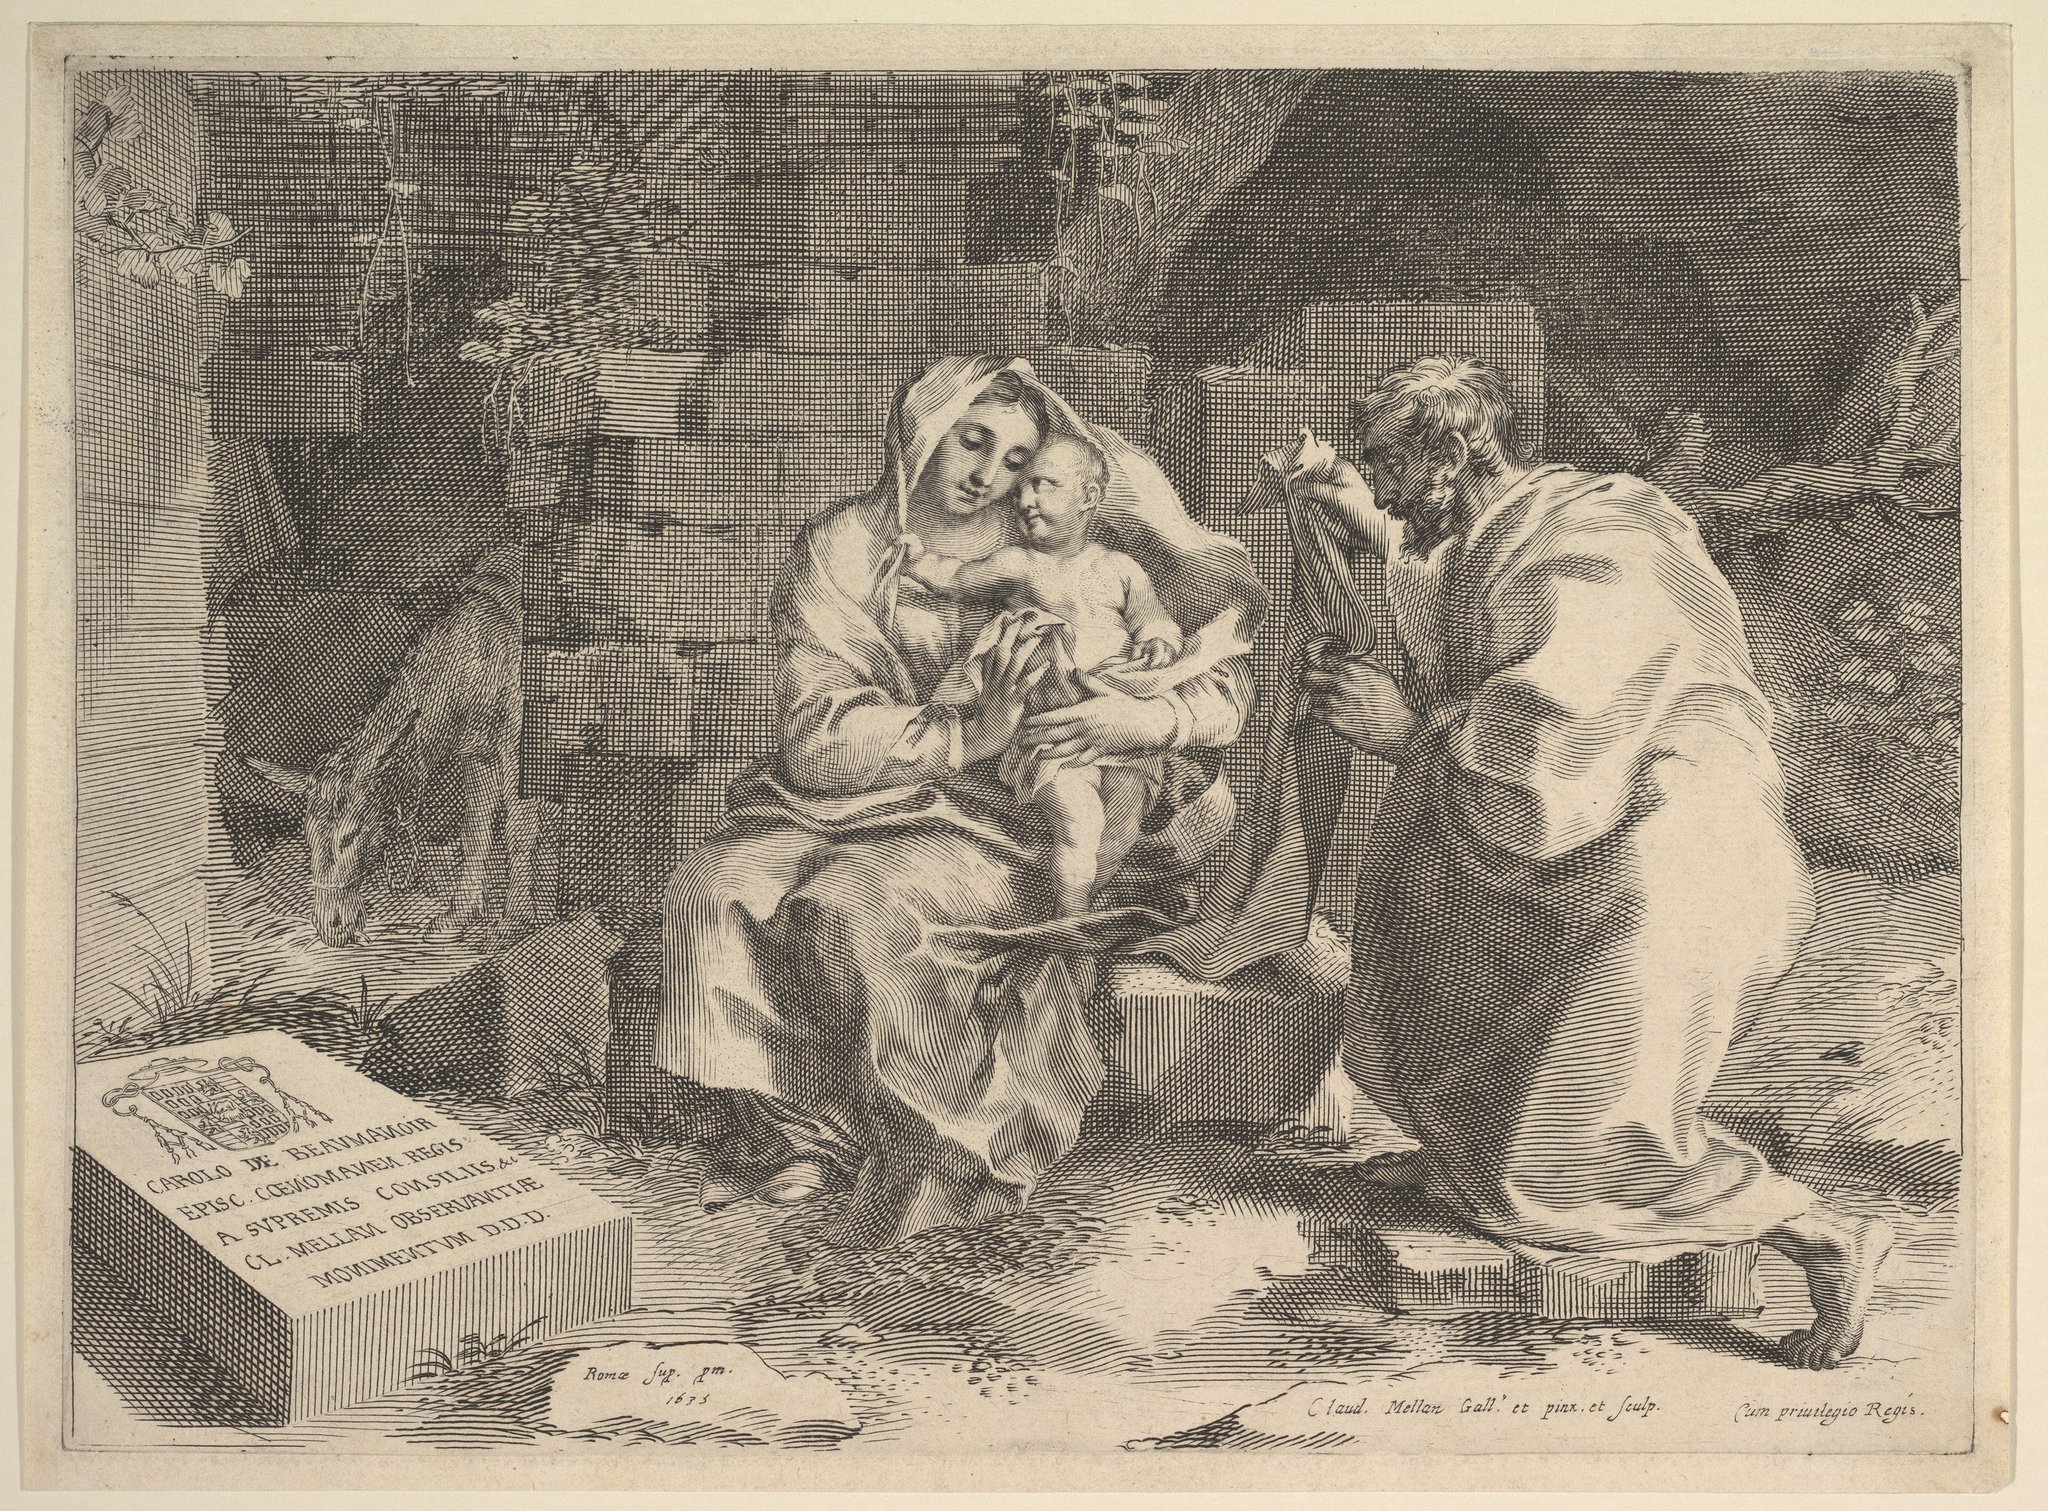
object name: print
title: Holy Family (Repos pendant la fuite en Égypte)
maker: claude mellan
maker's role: artist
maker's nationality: french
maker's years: 1598-1688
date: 1635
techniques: engraving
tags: holy family